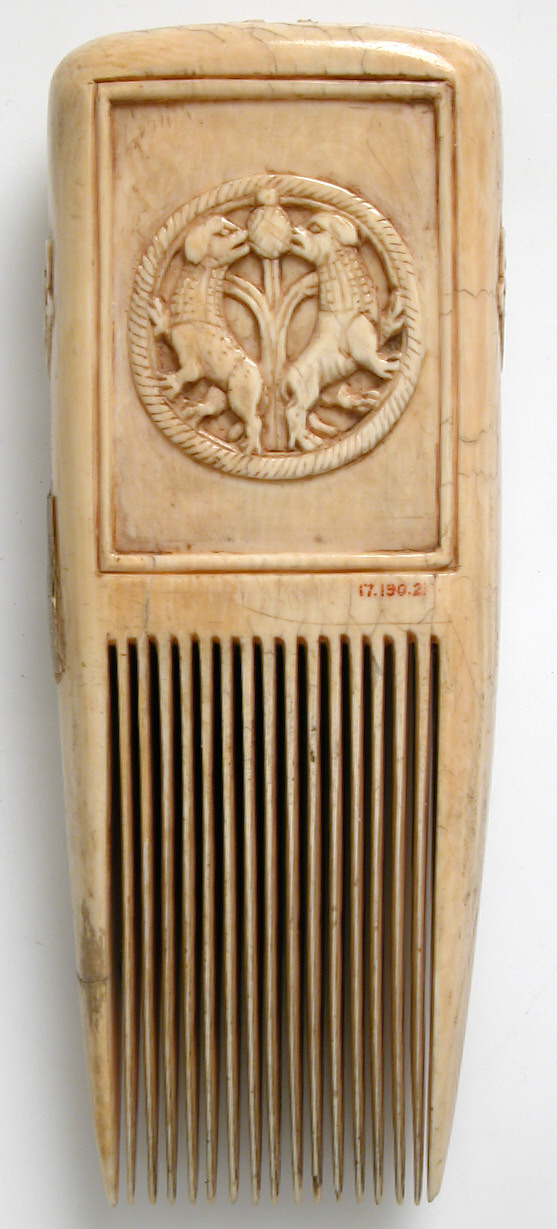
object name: comb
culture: european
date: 1801-1900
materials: ivory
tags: lions